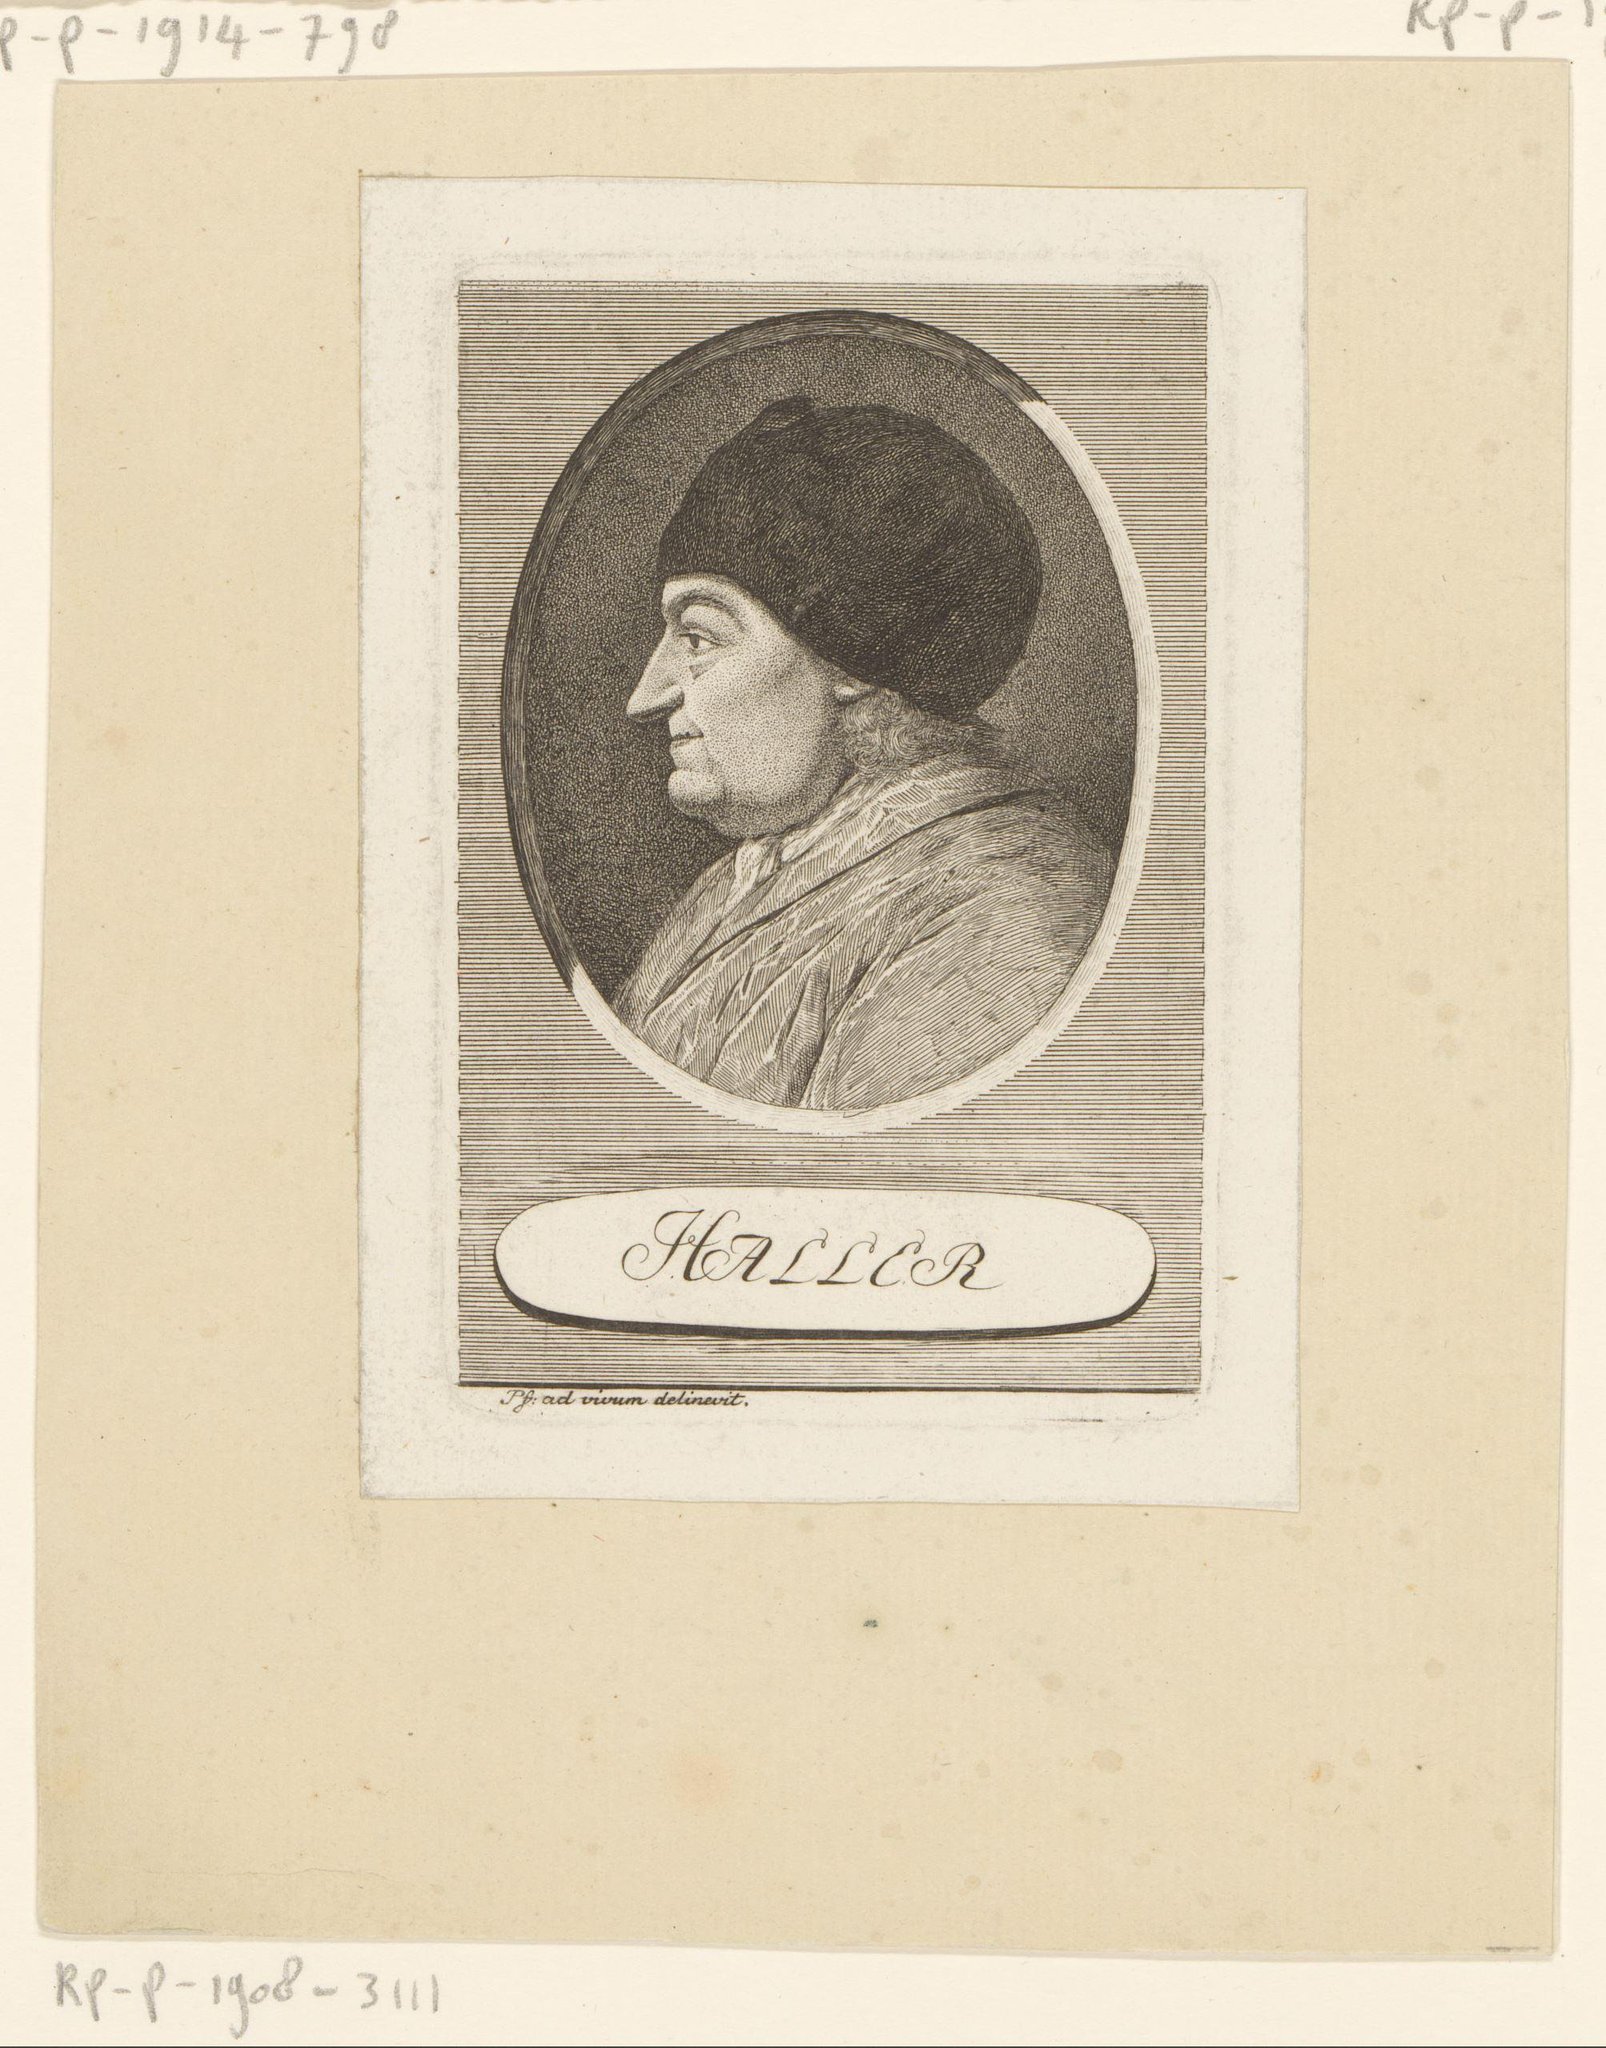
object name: print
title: Portret van Albrecht Haller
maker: heinrich pfenninger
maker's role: print maker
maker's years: 1749-1815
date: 1759-1815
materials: paper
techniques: etching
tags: physicist, historical persons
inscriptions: collector's mark: Lugt 2228